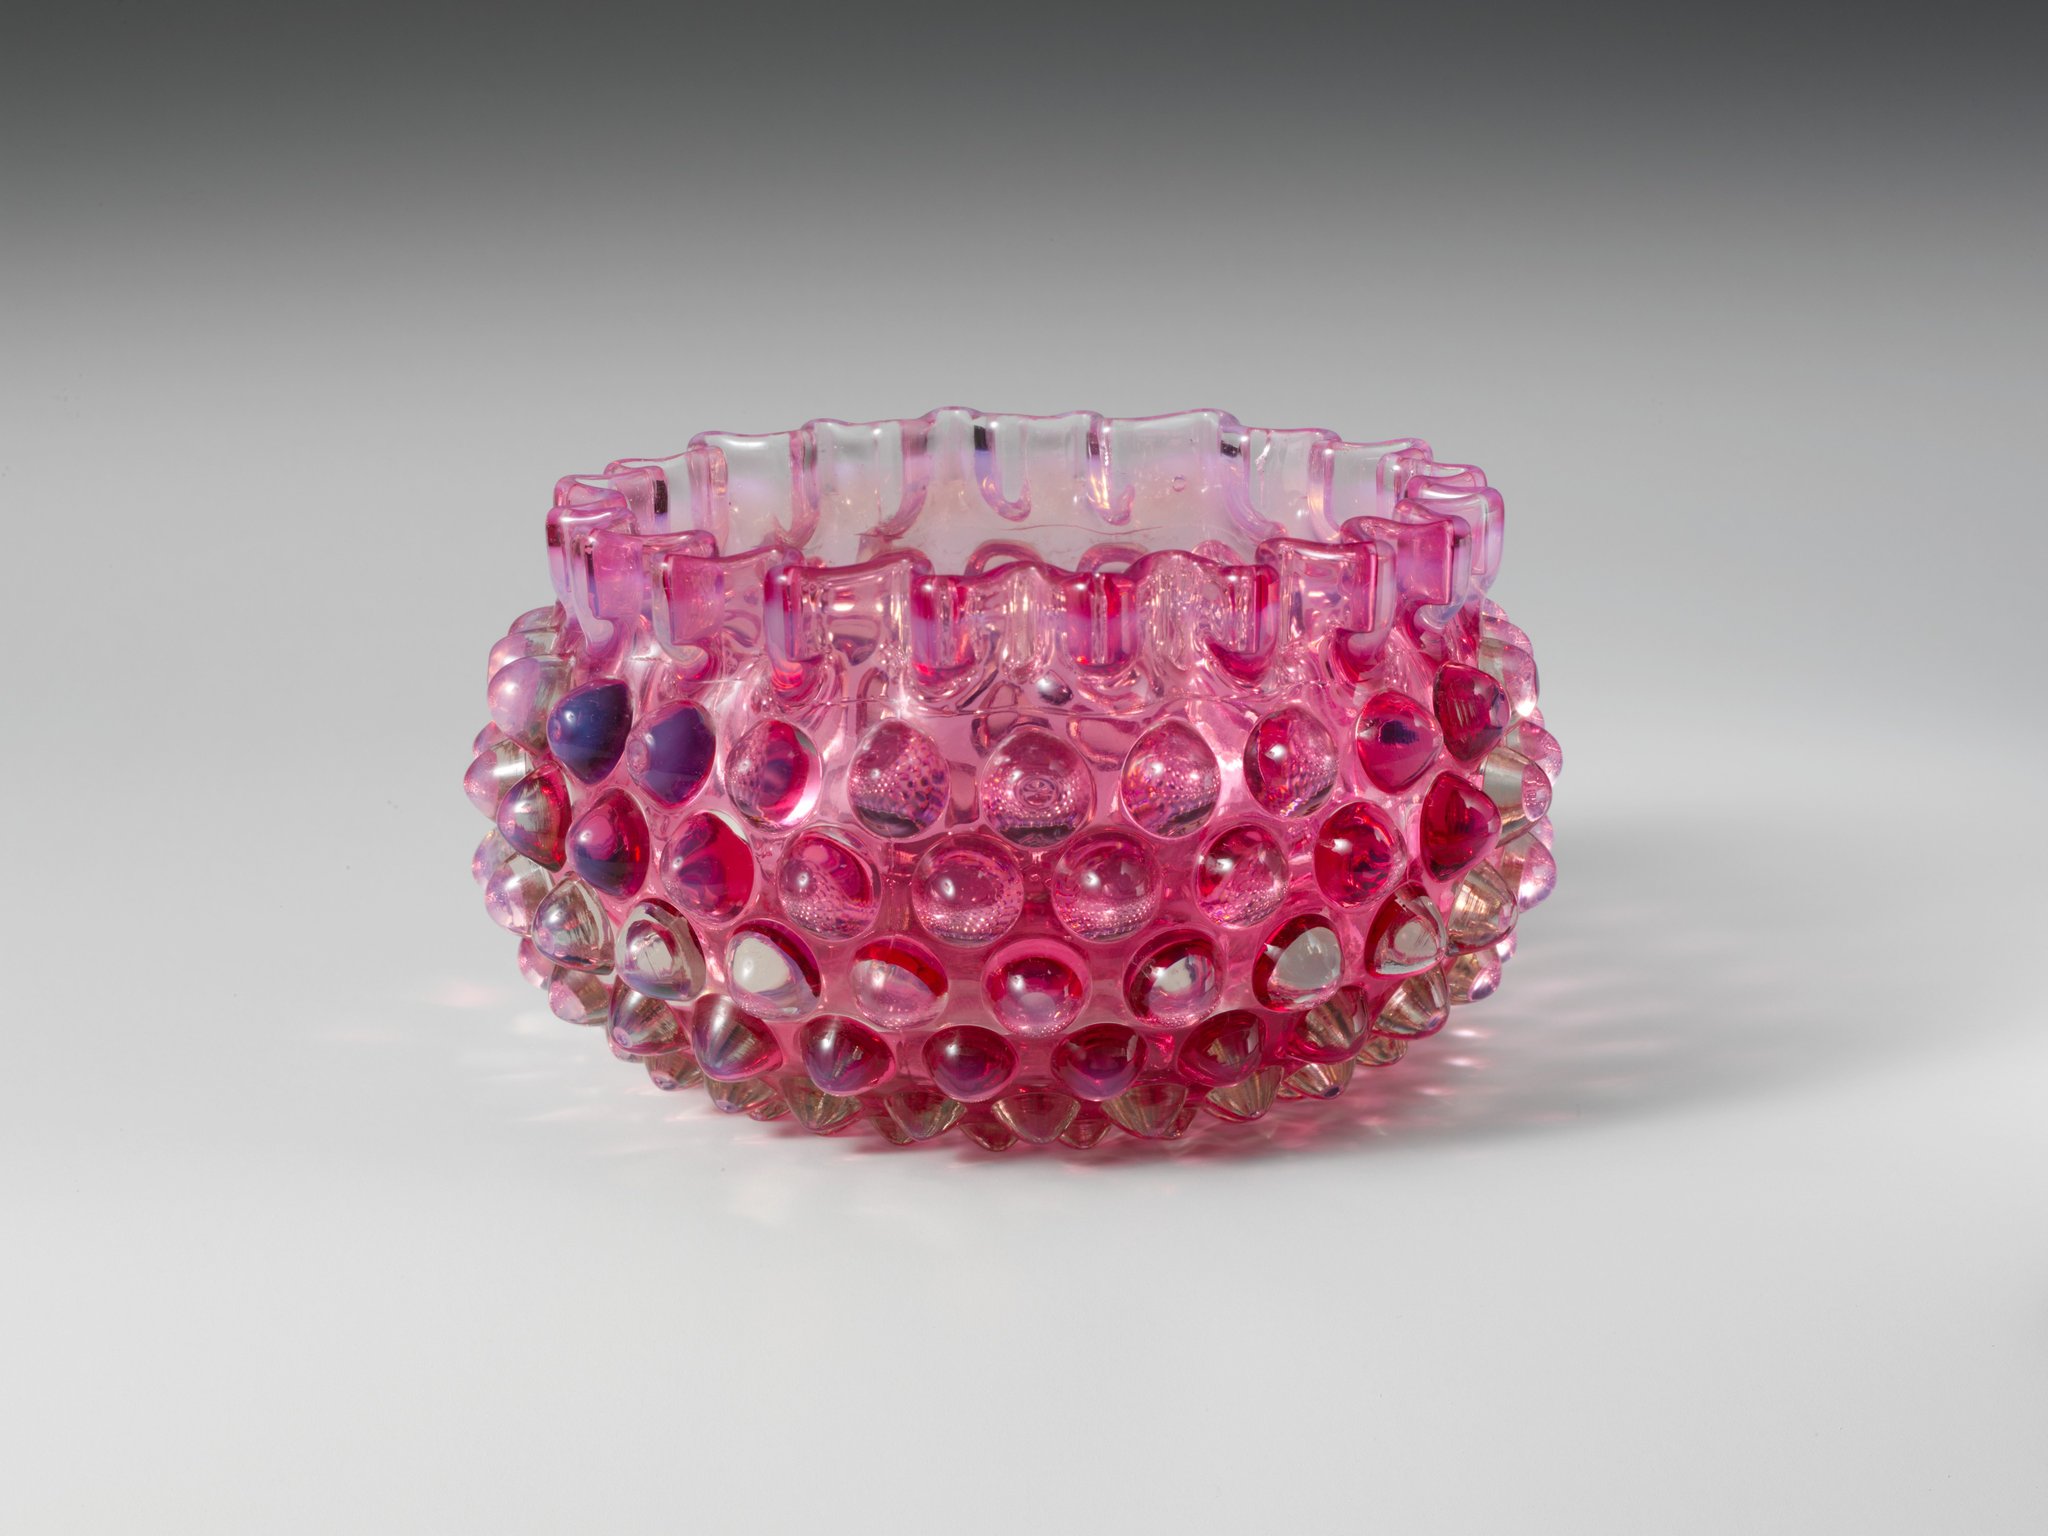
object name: finger bowl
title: Hobnail Finger Bowl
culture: american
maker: hobbs, brockunier and company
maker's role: maker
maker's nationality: american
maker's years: 1863-1891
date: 1886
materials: glass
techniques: pressed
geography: united states